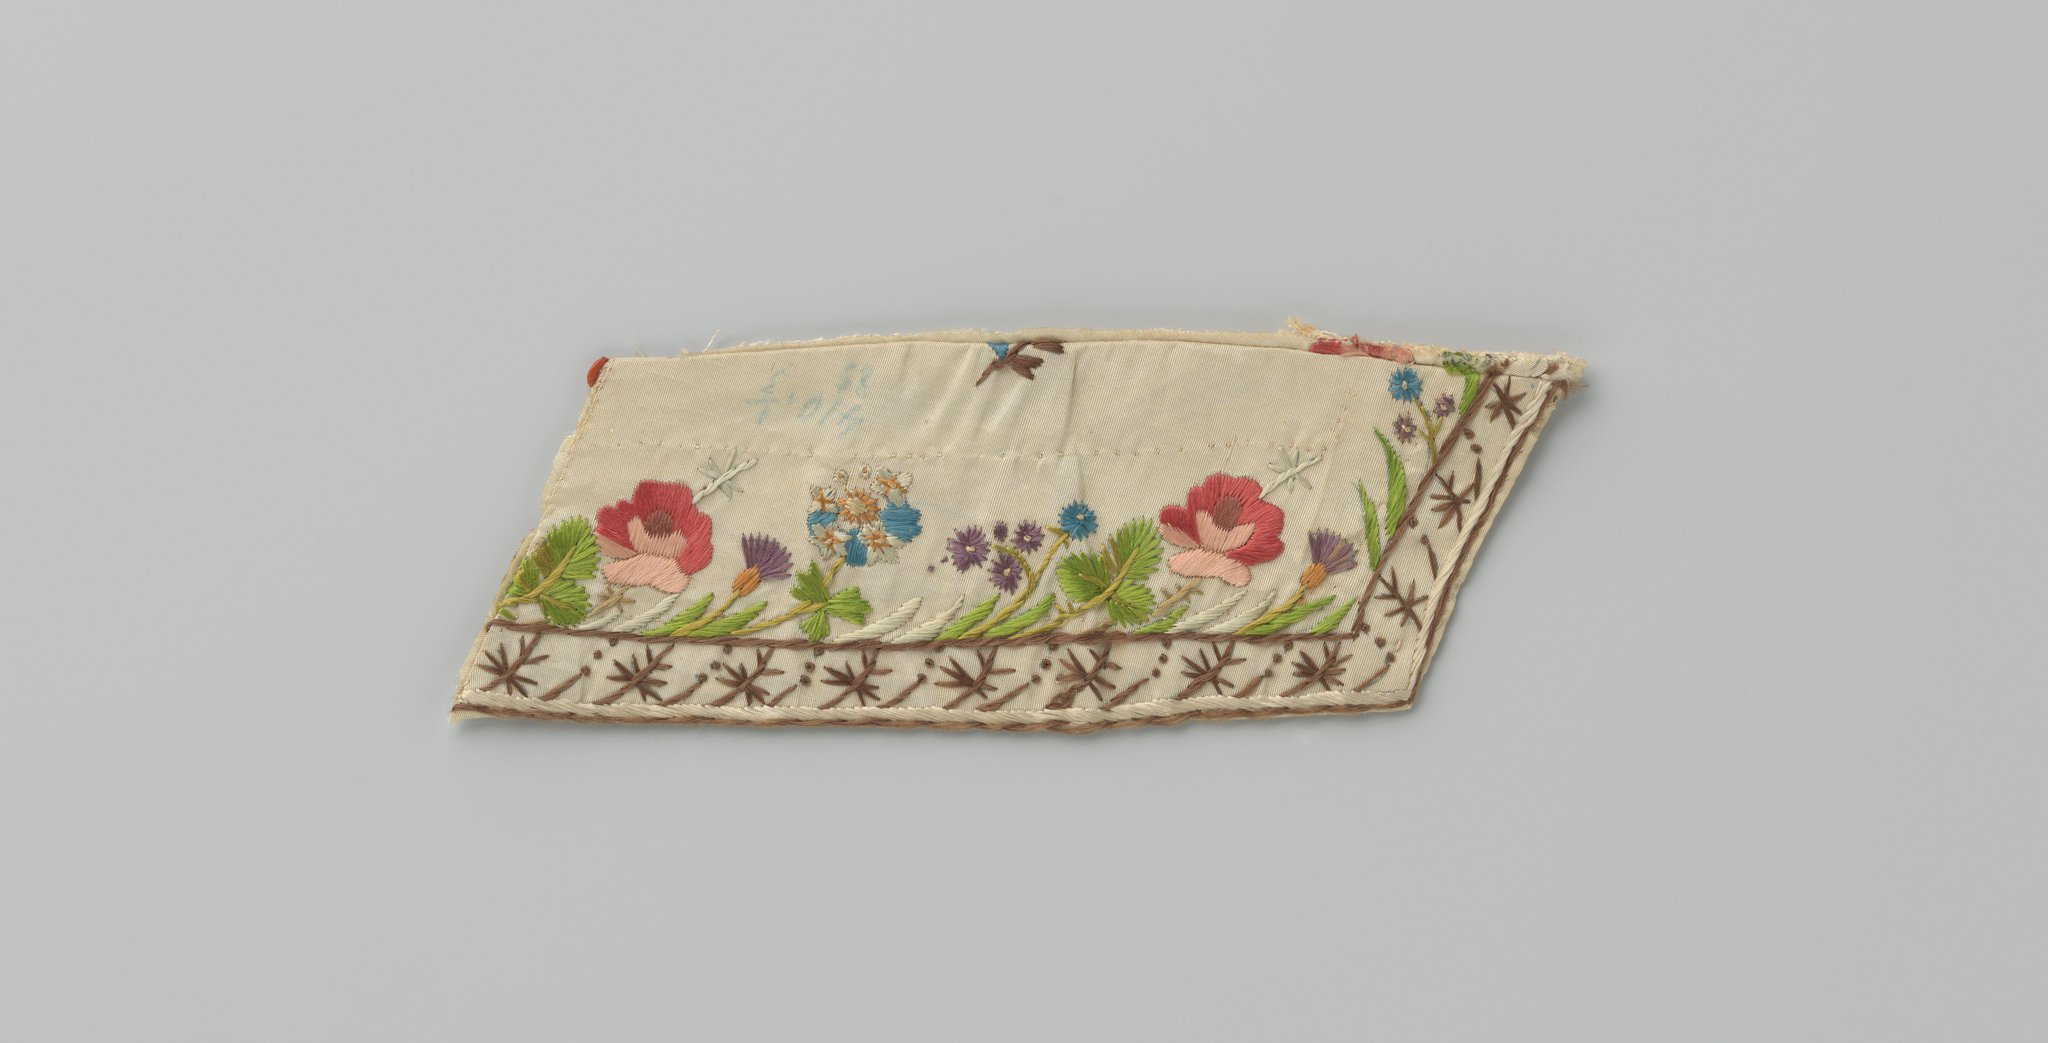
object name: woven material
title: Fragment met borduurwerk met bloemen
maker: Anonymous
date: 1800-1930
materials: textile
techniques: embroidered, weave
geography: europe